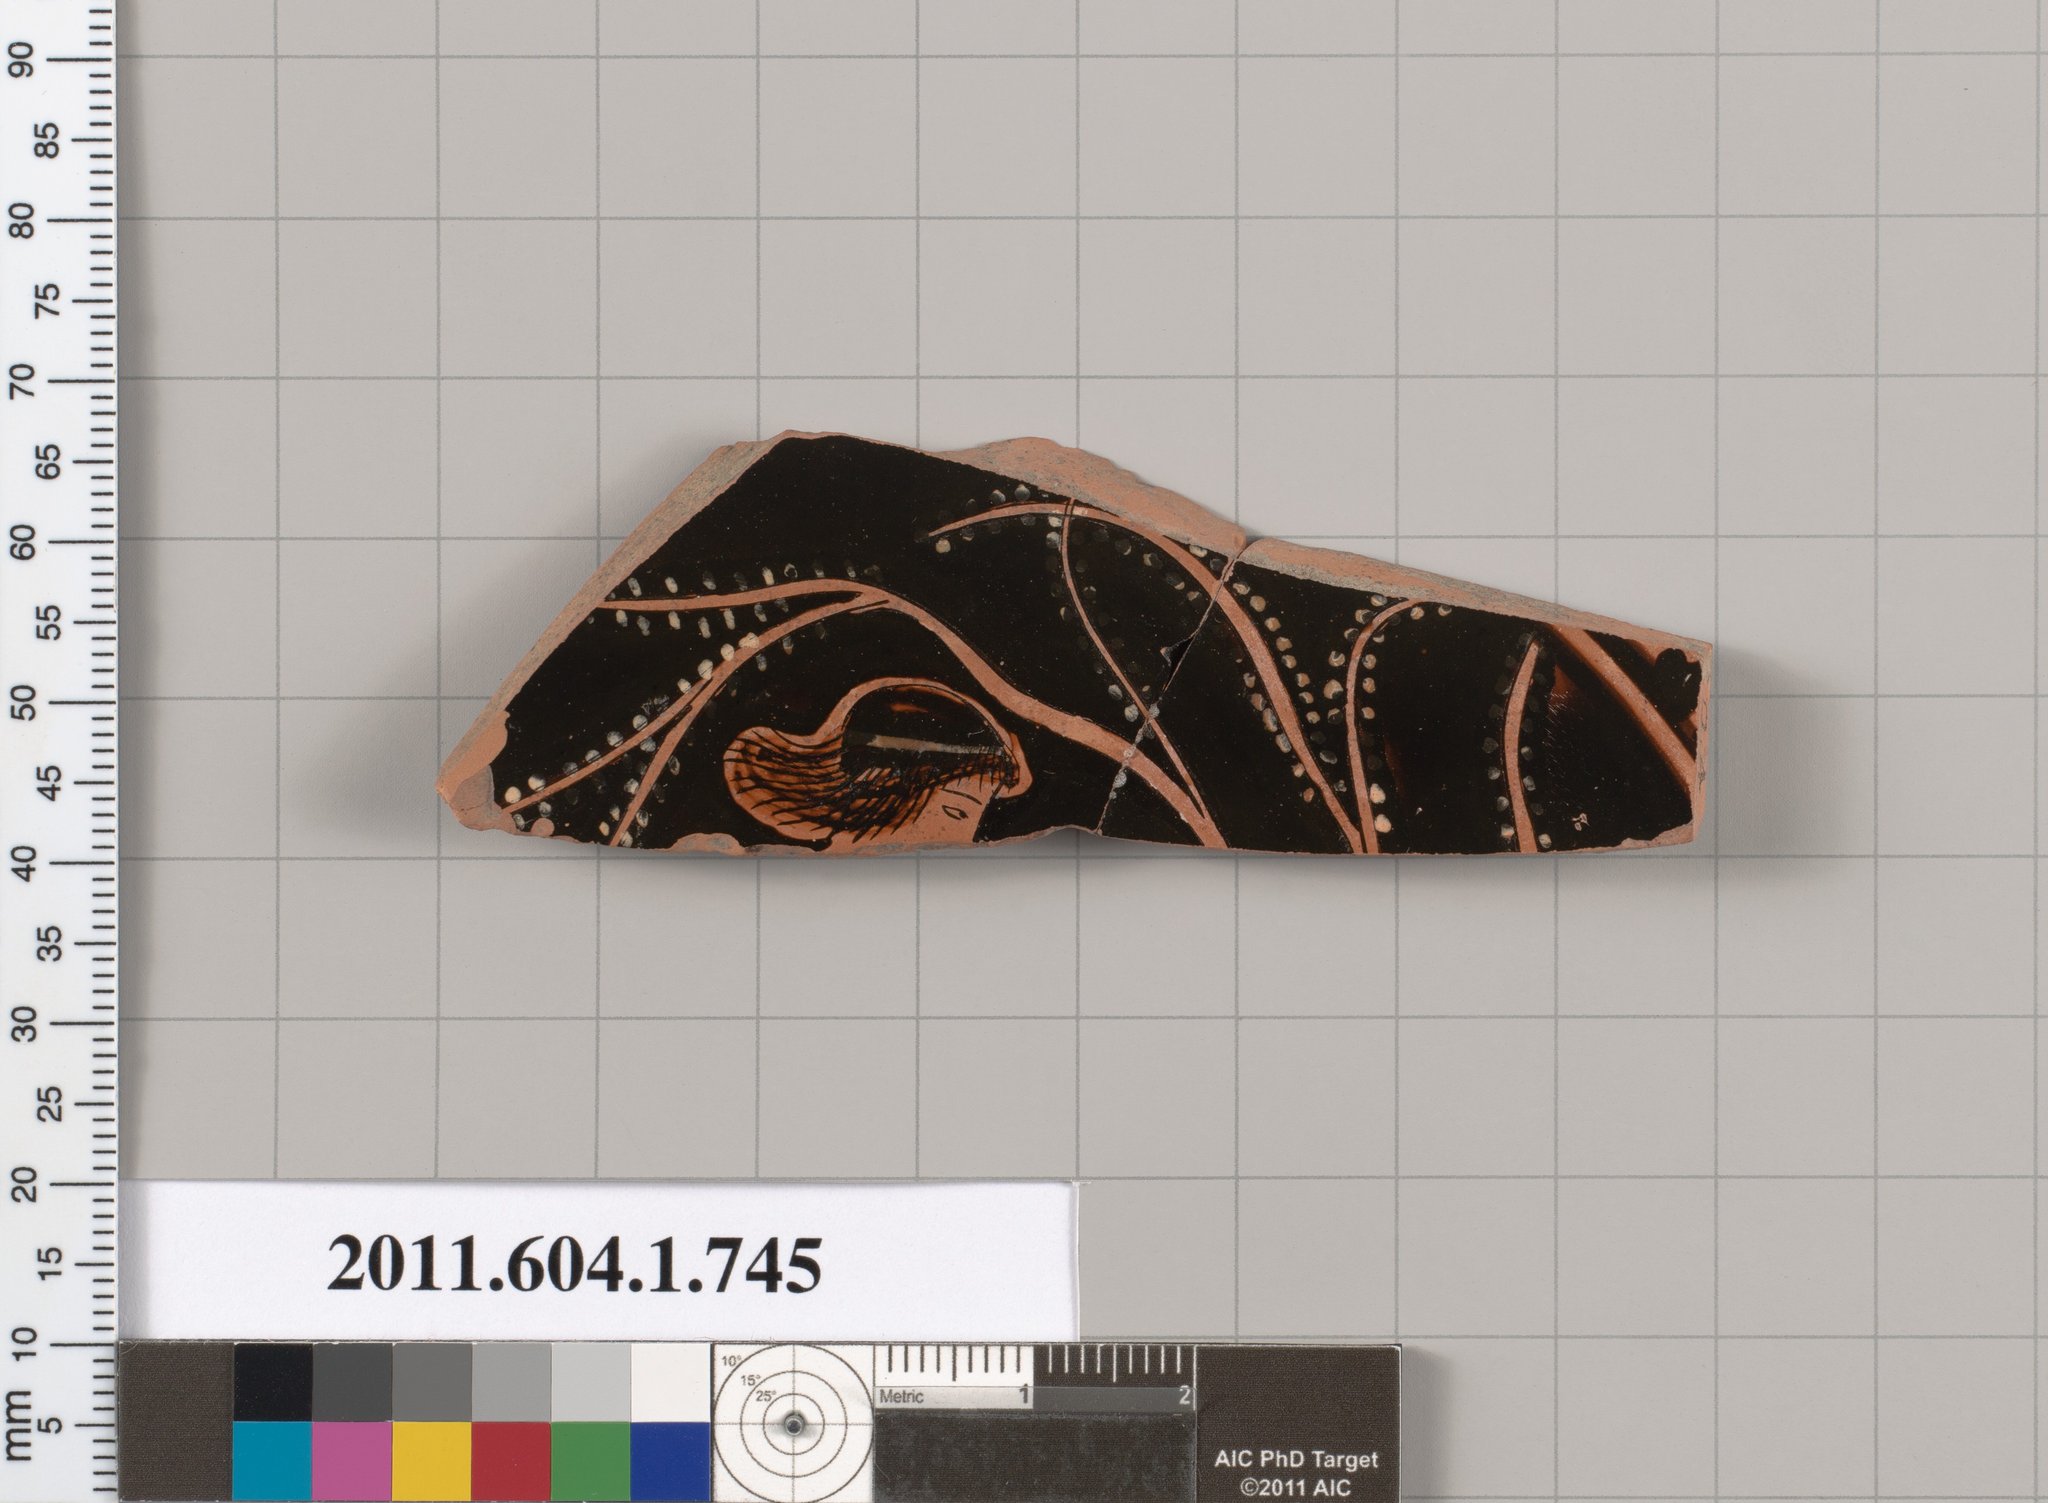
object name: kylix fragment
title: Terracotta fragment of a kylix (drinking cup)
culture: greek, attic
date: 490-480 BCE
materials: terracotta